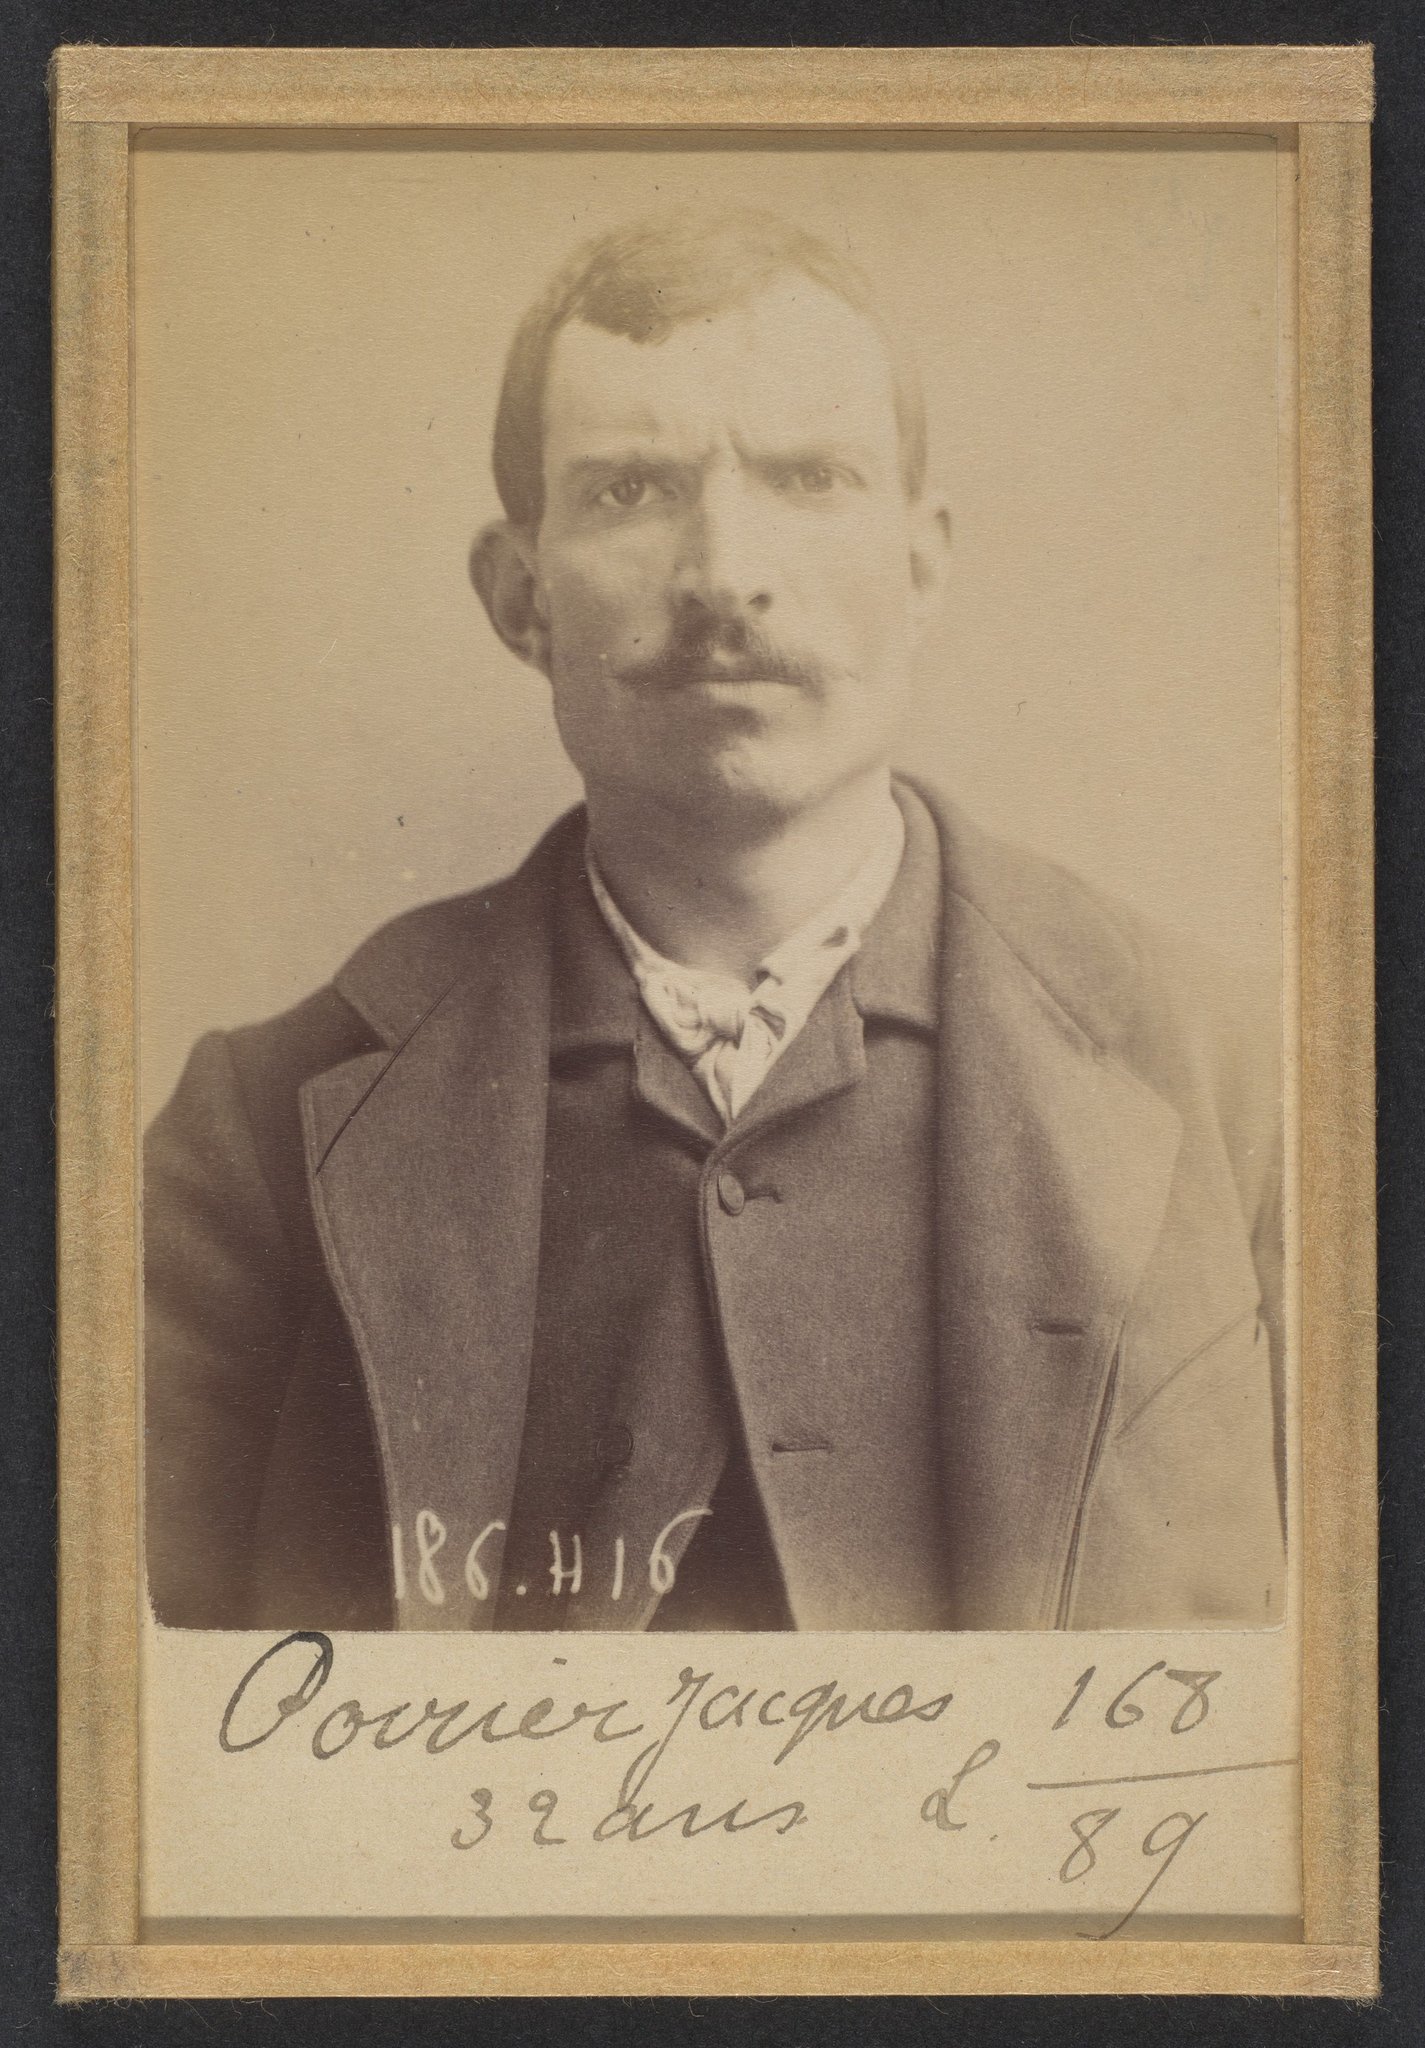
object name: mugshot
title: Poirier. Jacques, Étienne. 30 ans, né à Gien (Loiret). Garçon de marchand de vins. Anarchiste. 30/4/92.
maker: alphonse bertillon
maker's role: artist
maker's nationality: french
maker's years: 1853-1914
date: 1892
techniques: albumen silver print, glass negative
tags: men,portraits